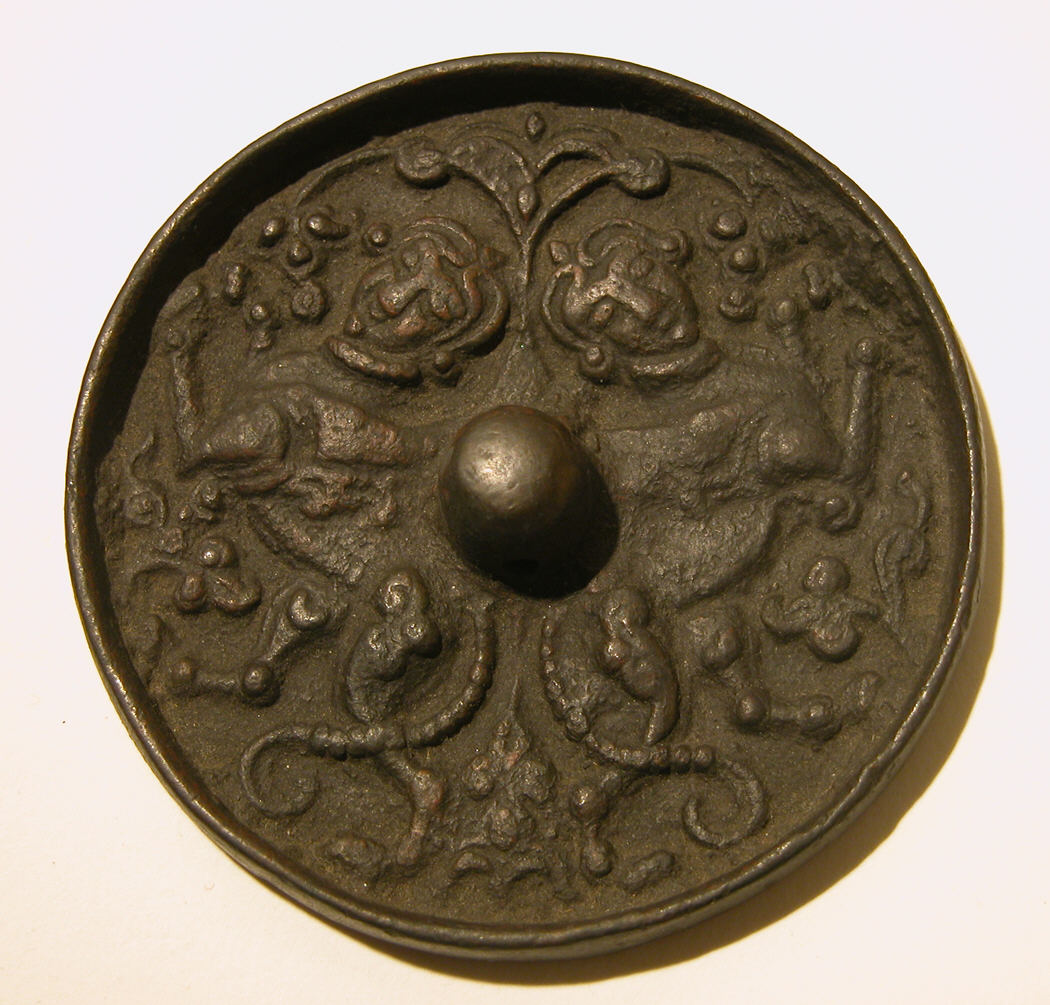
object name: mirror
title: Mirror with a Pair of Addorsed Sphinxes with Scorpion Tails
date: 1101-1300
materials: bronze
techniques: casting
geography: iran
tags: sphinx